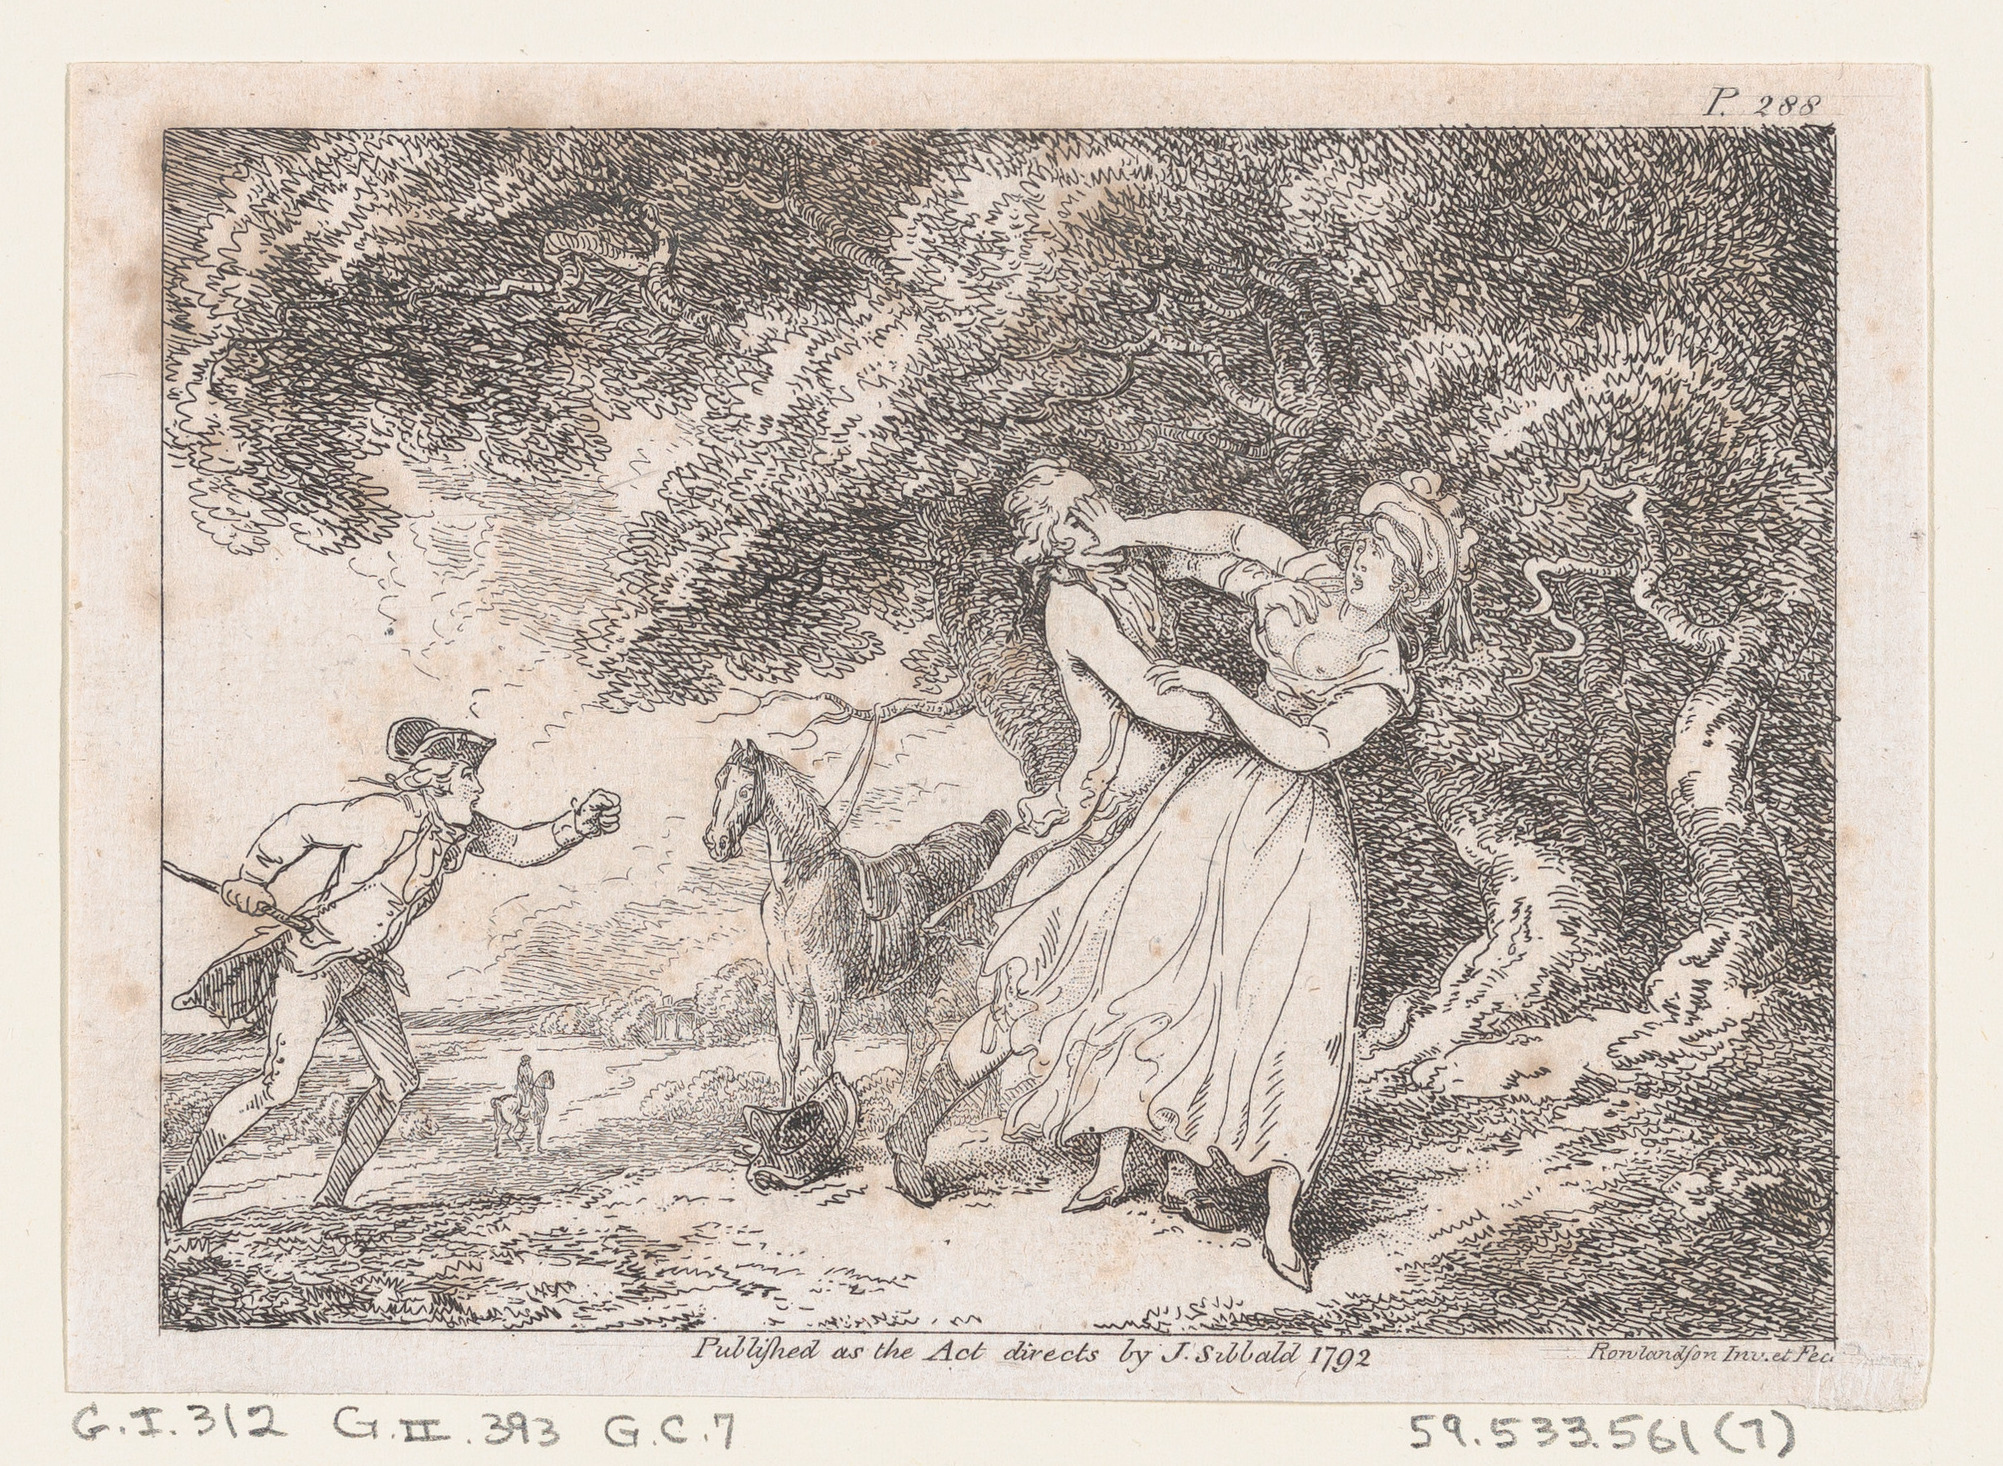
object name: print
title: Joseph Hastens to Rescue Fanny from Imminent Danger, from "The Adventures of Joseph Andrews, and his friend Mr. Abraham Adams"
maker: thomas rowlandson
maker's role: artist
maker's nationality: british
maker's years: 1757-1827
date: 1792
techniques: etching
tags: satire,men,female nudes,horses